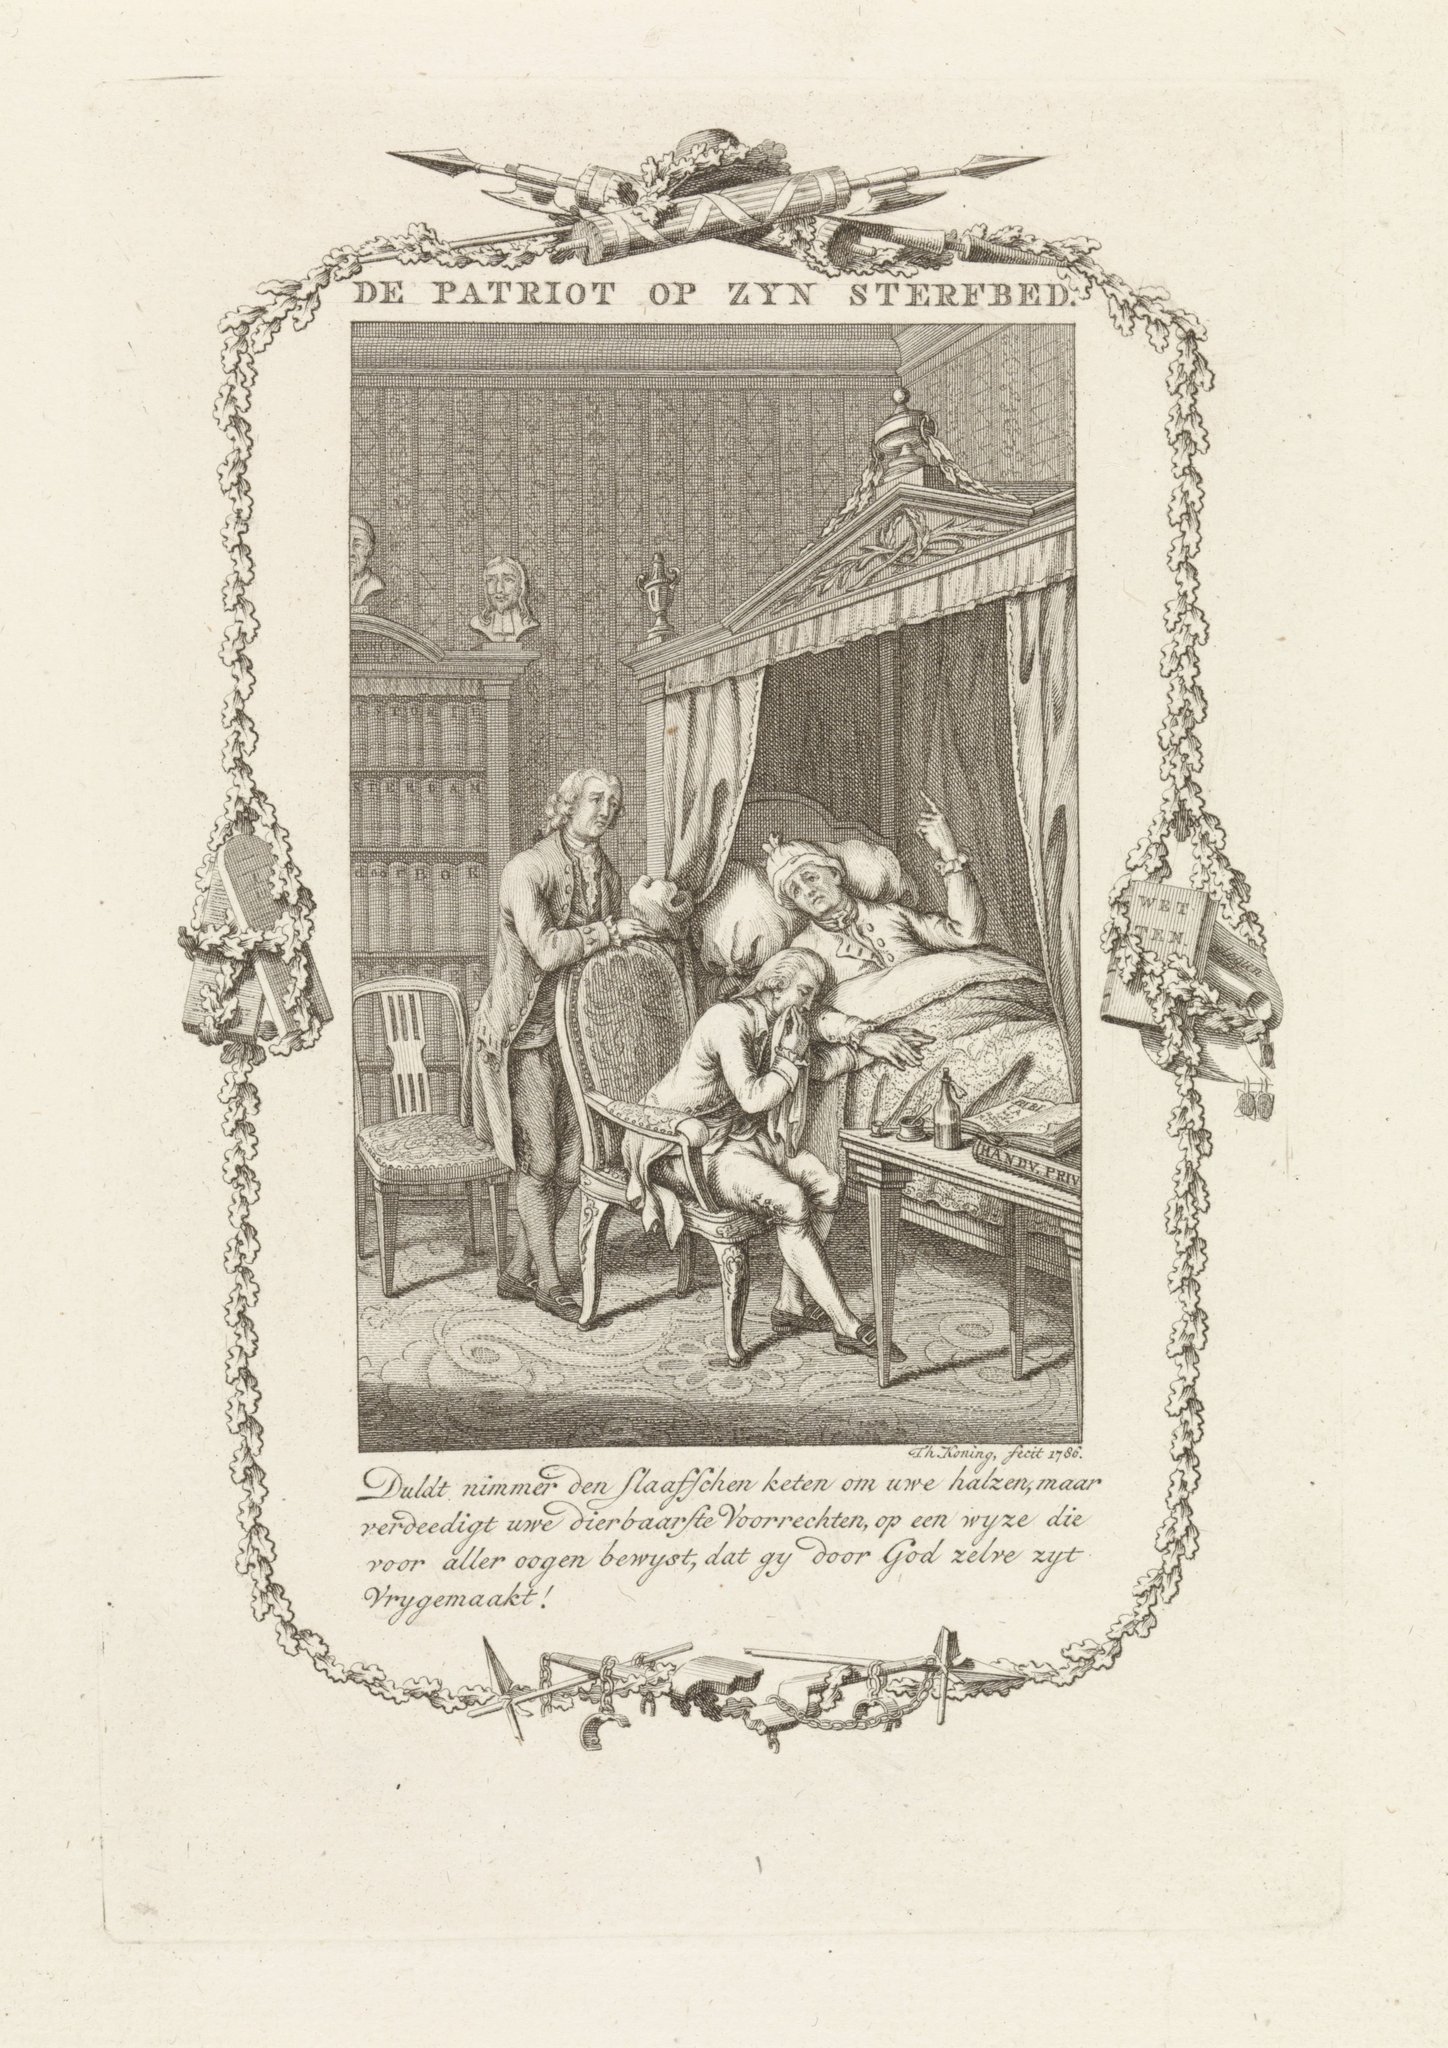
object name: print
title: Patriot op zijn sterfbed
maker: theodoor koning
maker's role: print maker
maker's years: 1748-1829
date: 1786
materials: paper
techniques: etching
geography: amsterdam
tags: writing tools, deathbed, weeping, patriot (revolutionary)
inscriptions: collector's mark: Lugt 2760, collector's mark: Lugt 2228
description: In een interieur ligt een patriot op zijn sterfbed. Aan zijn bed bevinden zich twee treurende mannen. Op een tafeltje naast het sterfbed ligt schrijfgerei en een opengeslagen Bijbel. Onder de afbeelding een vierregelig onderschrift. De afbeelding is gevat in een omlijsting van eikenbladeren met daarin fasces, grafzuilen en wetboeken.